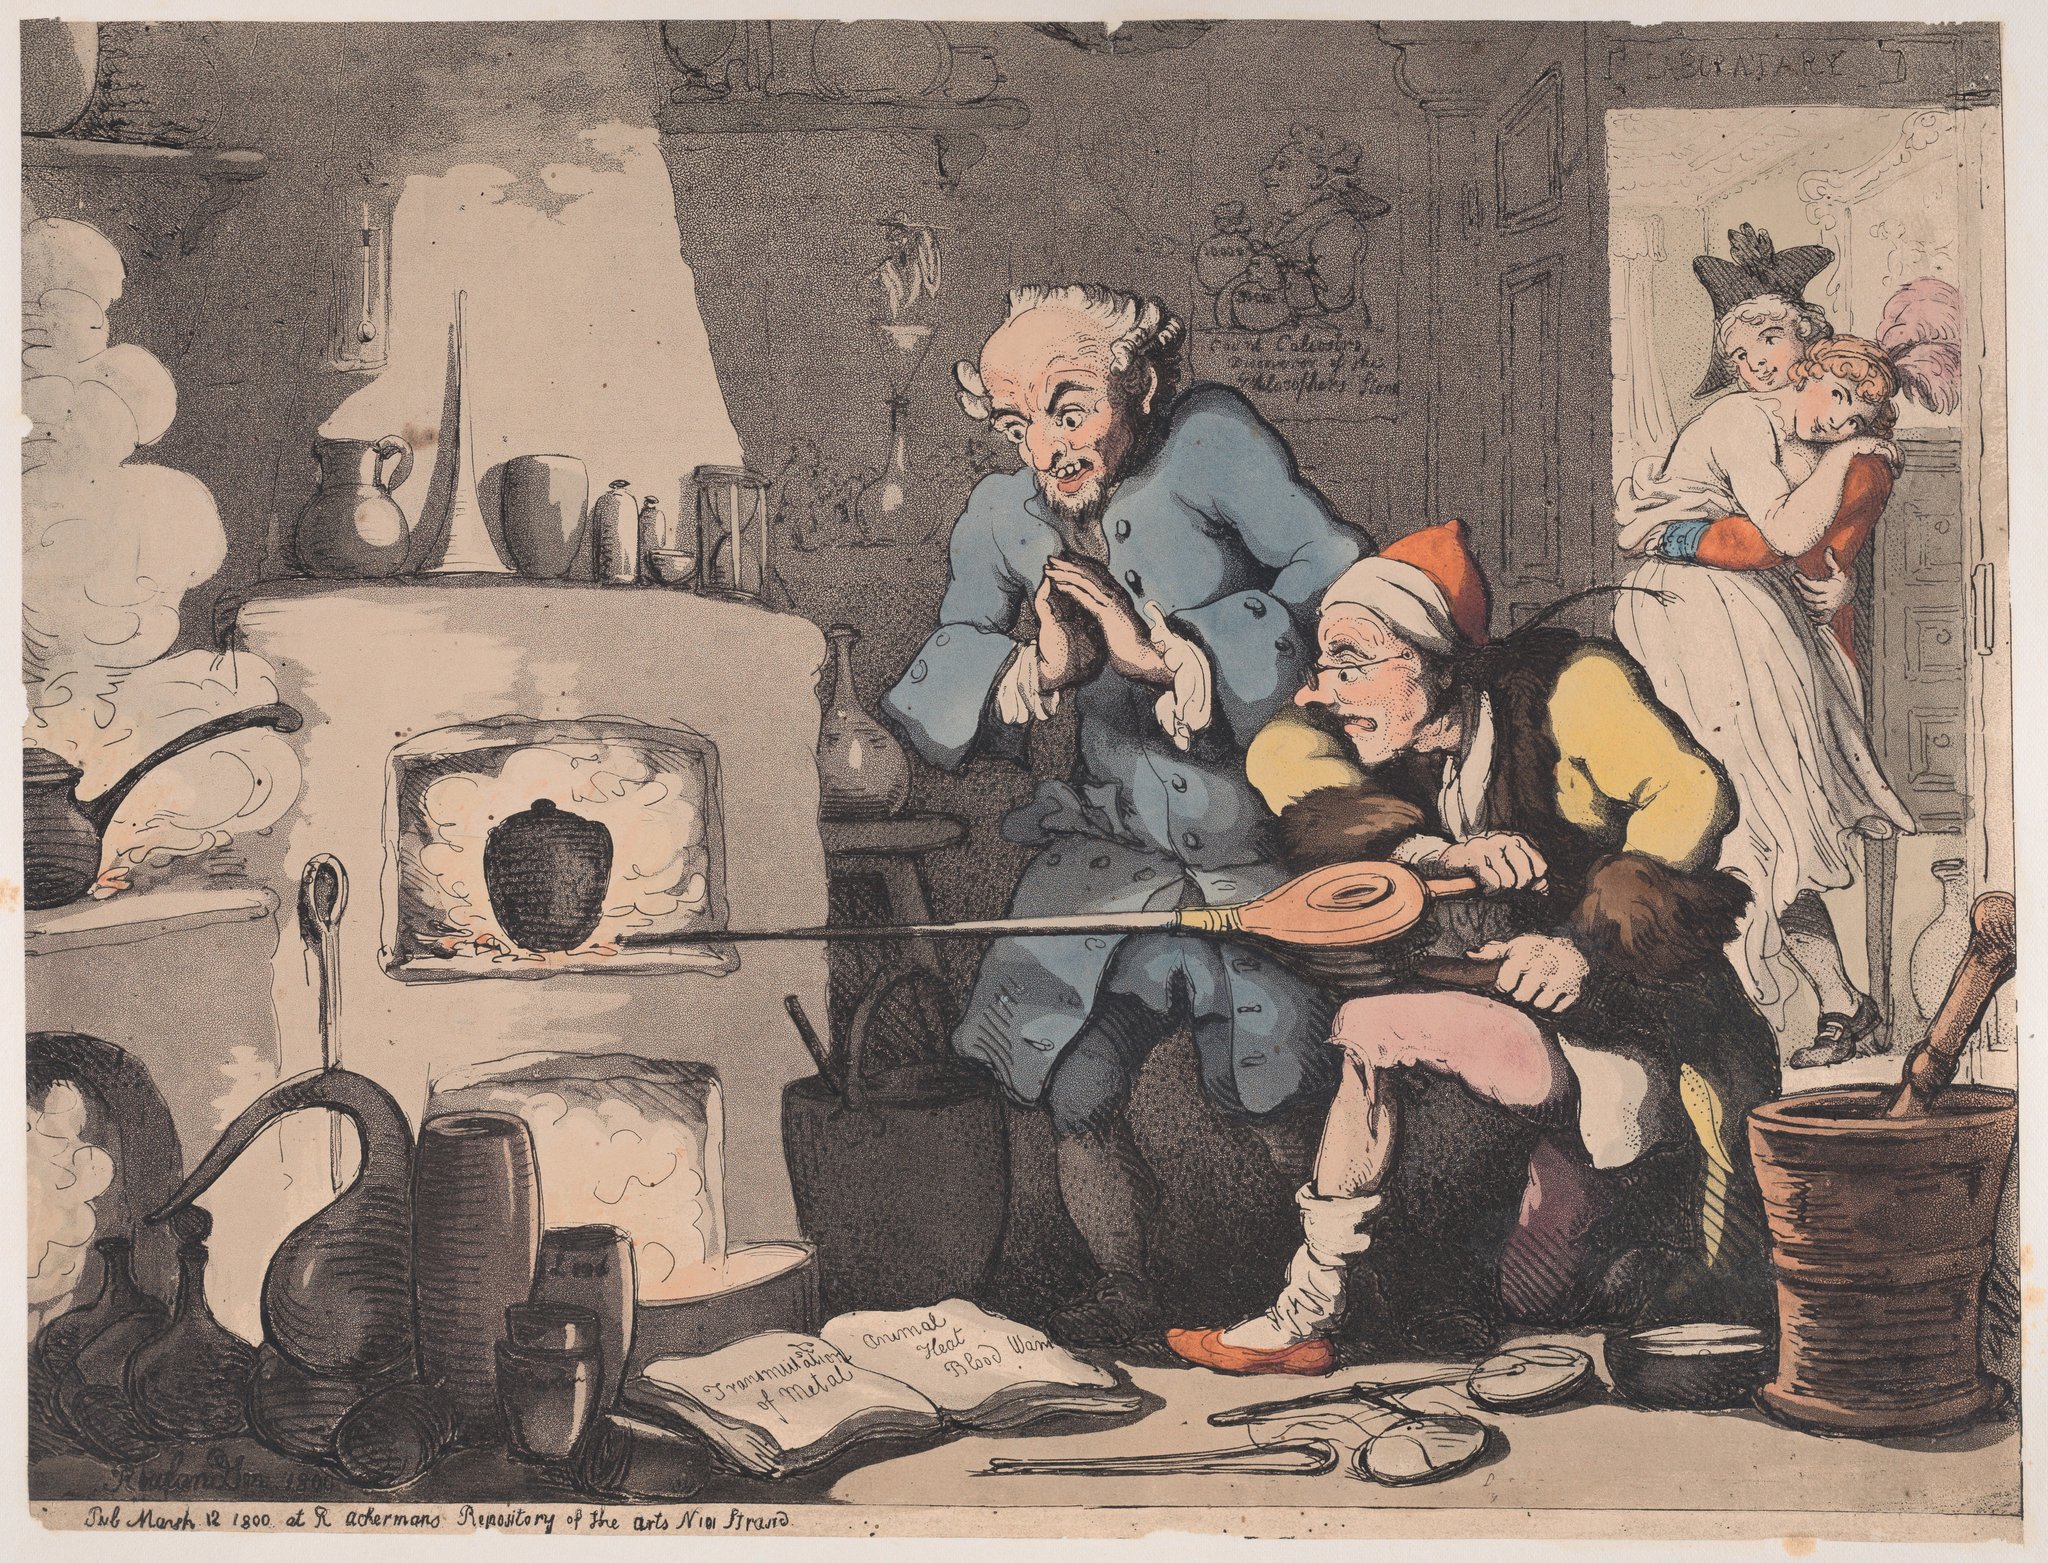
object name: print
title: Hocus Pocus, or Searching for the Philsopher's Stone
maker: thomas rowlandson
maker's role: artist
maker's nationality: british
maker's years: 1757-1827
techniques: aquatint, etching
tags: satire,men,women